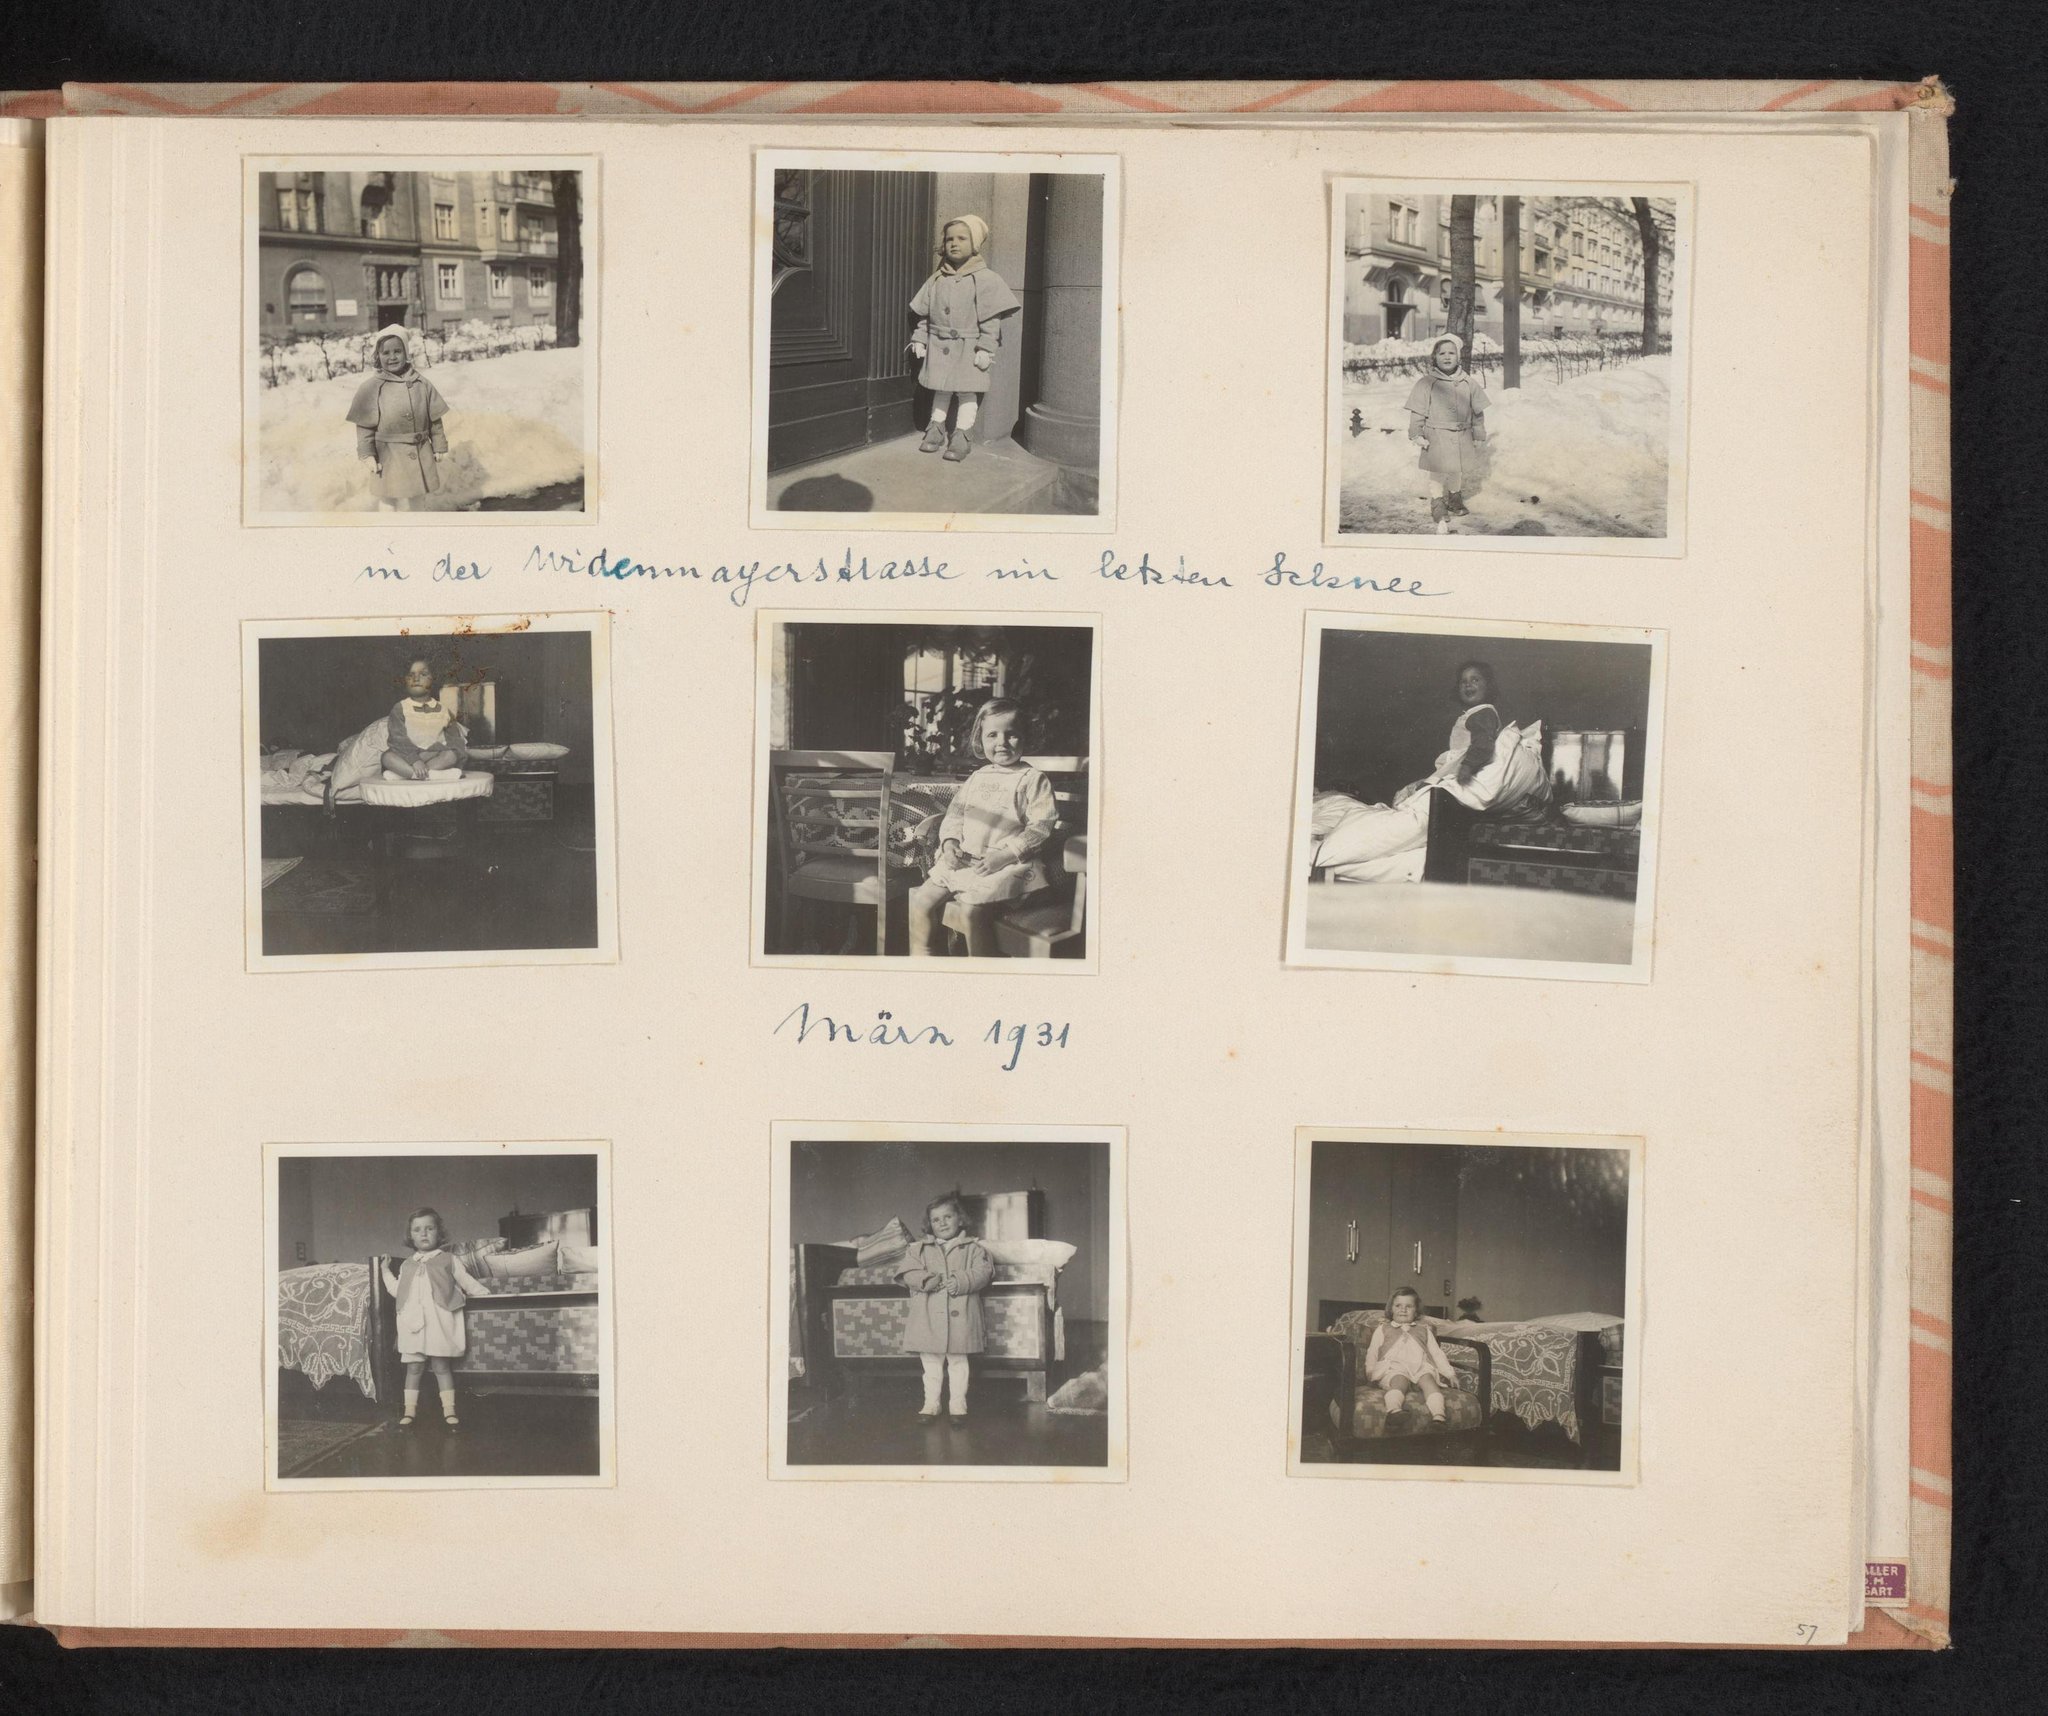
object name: photograph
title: Isabel Wachenheimer in de laatste sneeuw in de Widenmayerstrasse en in de slaapkamer van de familie Wachenheimer, maart 1931, München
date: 1903-1931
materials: paper, photographic support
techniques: gelatin silver print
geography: munich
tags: isabel wachenheimer-elon, family life at home, infant, baby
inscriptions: inscription: ‘in der Widenmayerstrasse im letzten Schnee März 1931’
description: Albumblad met negen foto's. Alle foto's, Isabel Wachenheimer. Onderdeel van het fotoalbum met foto's van Isabel Wachenheimer als kind (1928-1931).